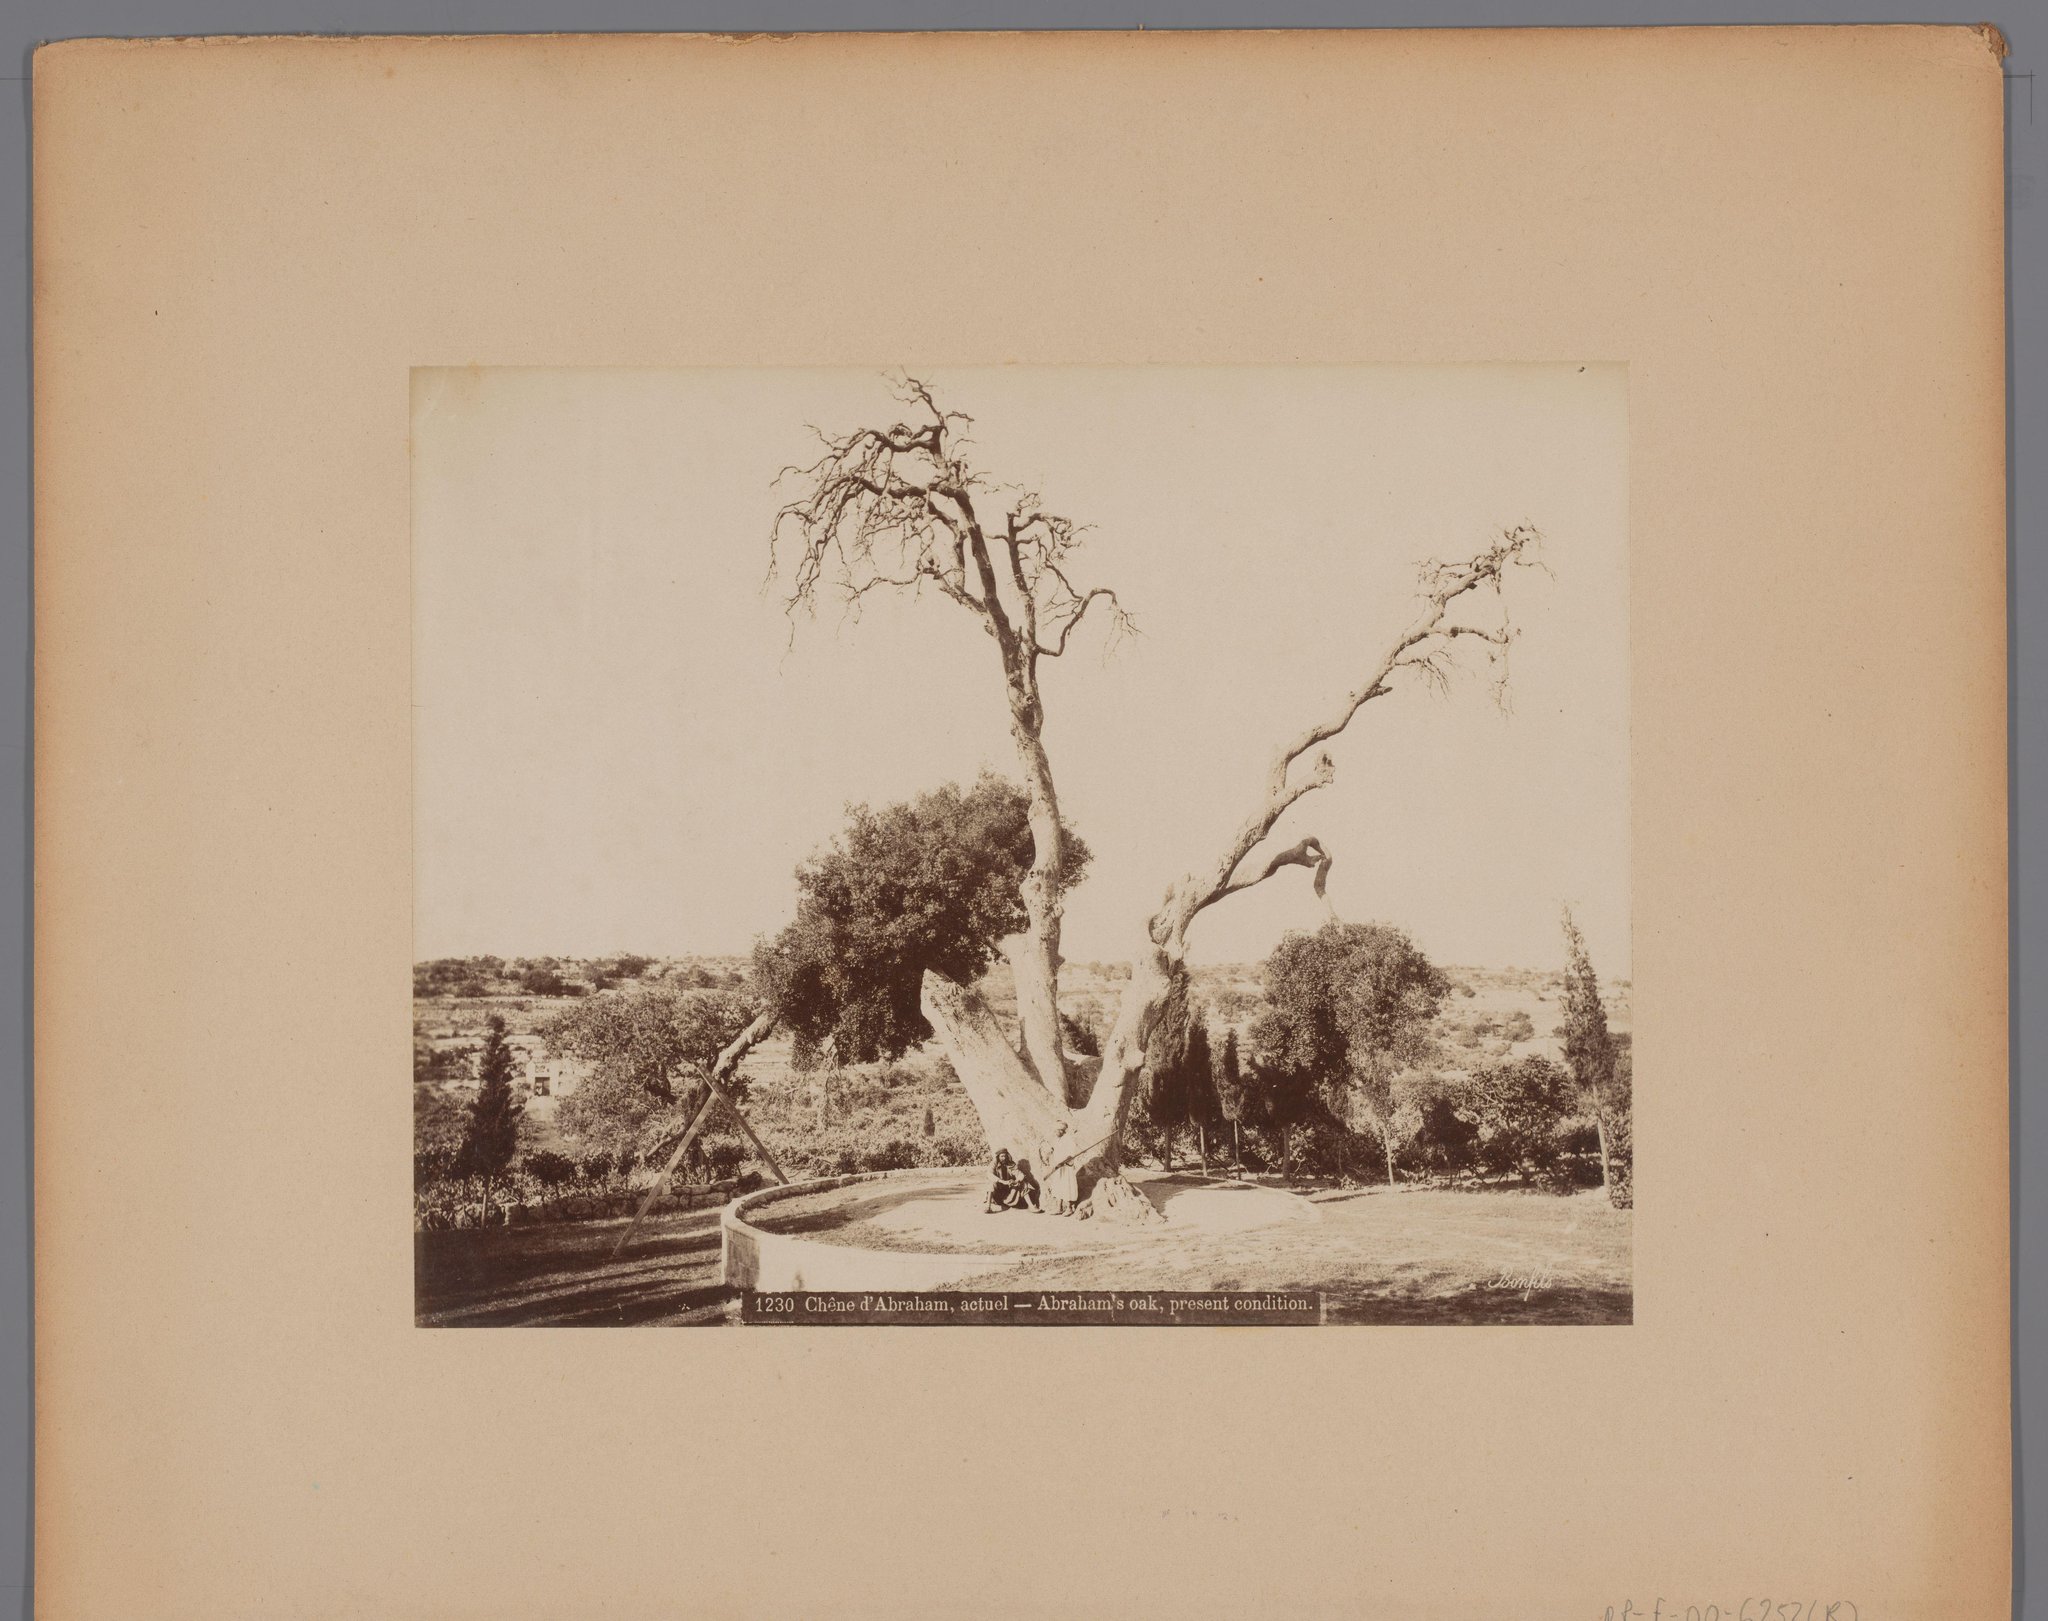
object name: photograph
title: Abrahams's Eik, Mamre, Palestina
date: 1850-1900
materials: cardboard, photographic support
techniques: albumen print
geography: paris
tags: palestina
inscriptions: inscription: ‘Bonfils’, inscription: ‘1230. Chêne dÁbraham, actuel - Abraham's oak, present condition’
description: Oude eik (Quercus pseudo-coccifera) op de plek waar Abraham een altaar bouwde (Genesis 13:18). De boom verkeerd volgens het opschrift in 'actuele' [=niet in een florisante] staat. Een staande man met lange stok/geweer [?] en een zittende man zijn nder de boom weergegeven.